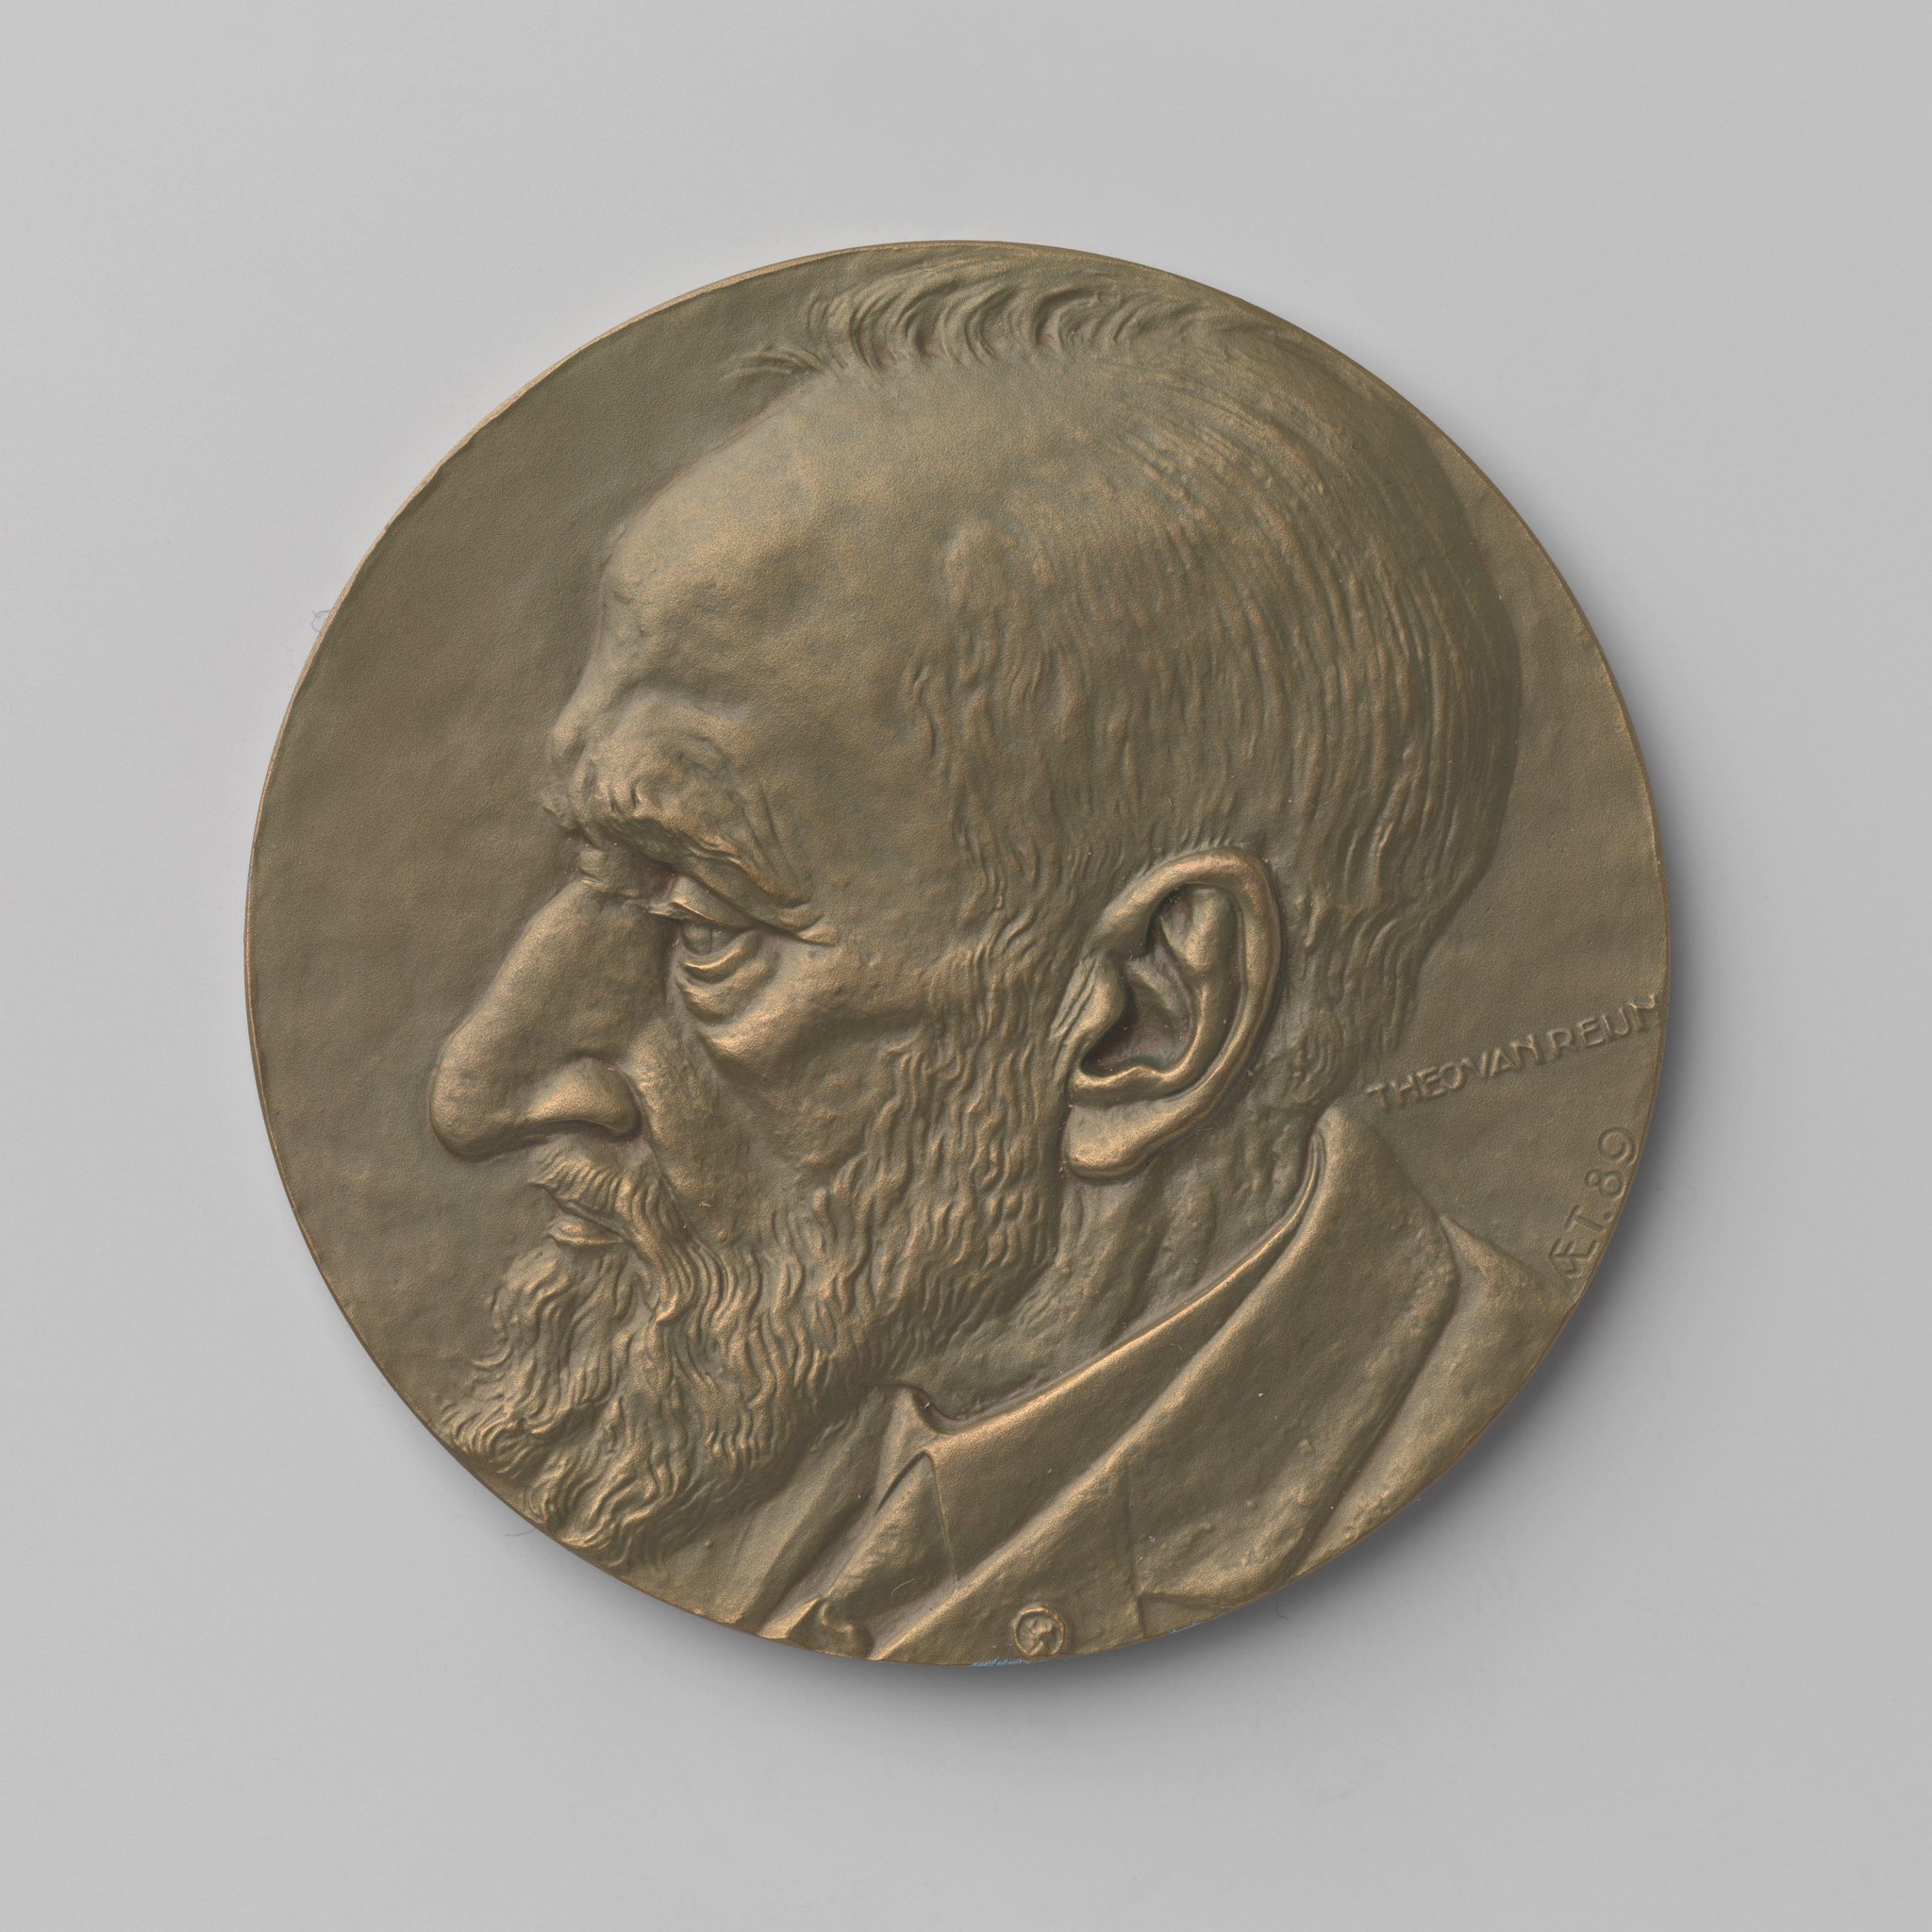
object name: history medal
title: Meester P.W.A. Cort van der Linden (Vereniging voor Penningkunst 1935, eerste penning)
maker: theo van reijn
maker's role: draughtsman, print maker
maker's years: 1884-1954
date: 1935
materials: bronze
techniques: striking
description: Bronzen penning, op de voorzijde het borstbeeld van Van der Linden naar links, op de keerzijde vier regels tekst onder een jaartal, met bovenaan omschrift.